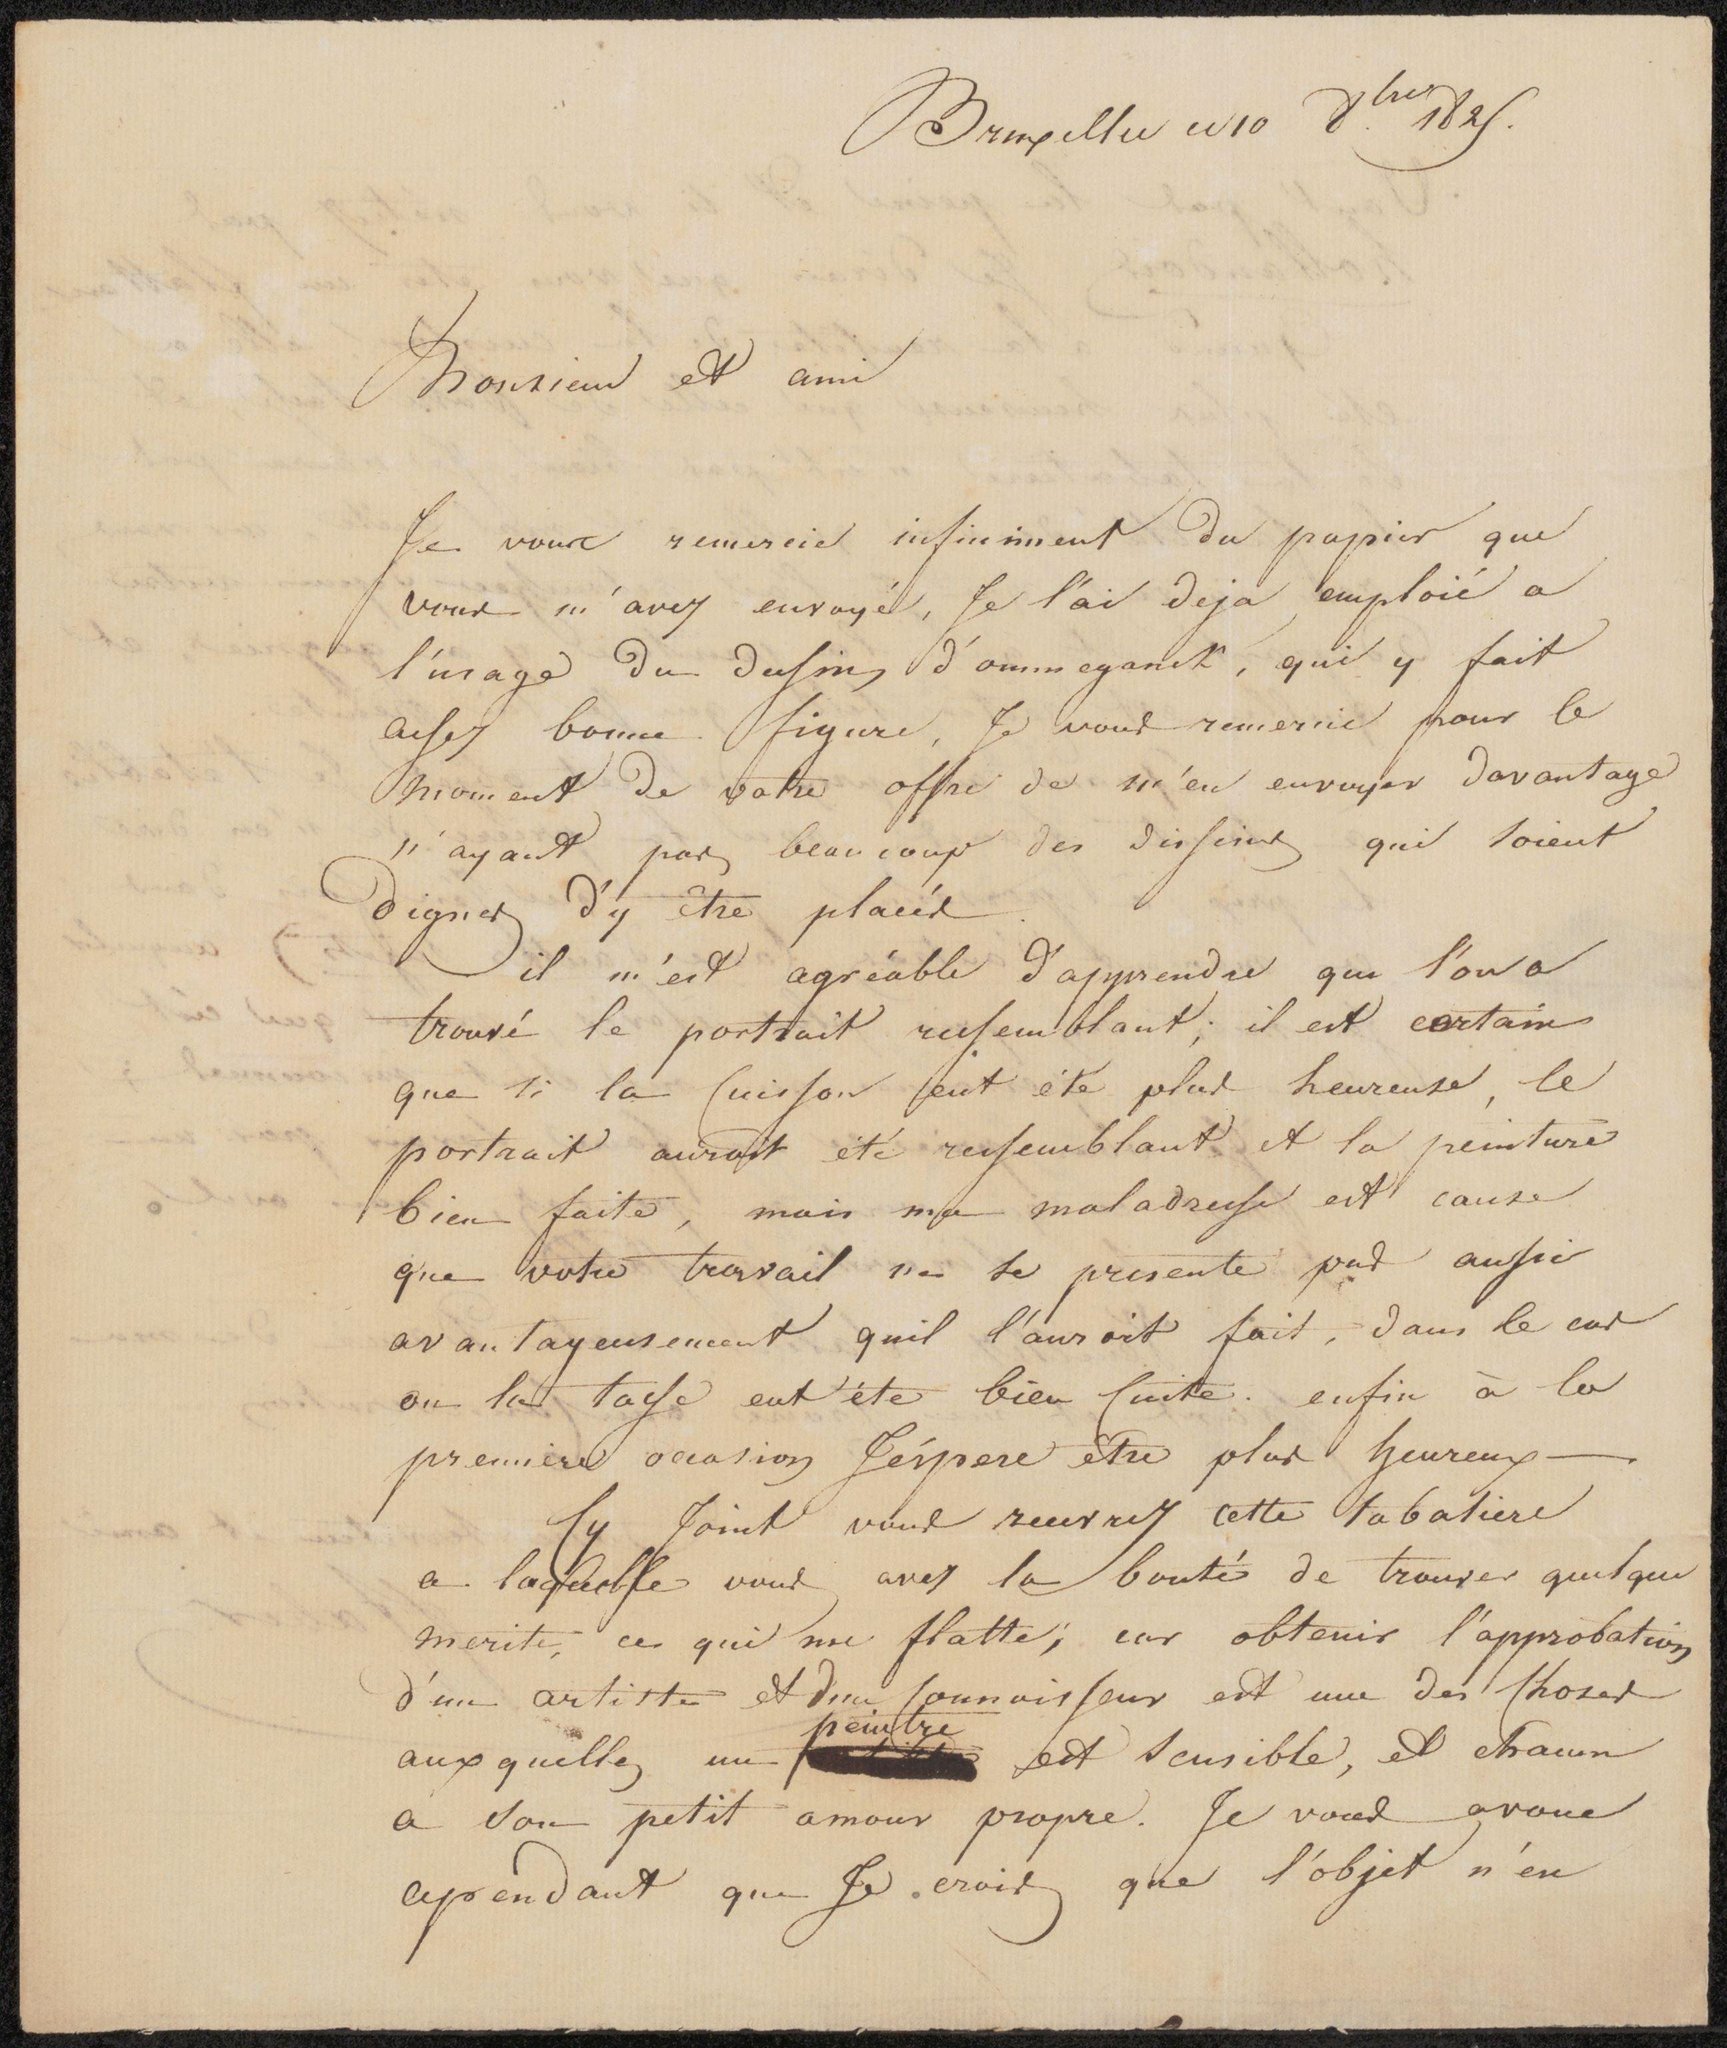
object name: letter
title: Brief aan Jean Zacharie Mazel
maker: frédéric théodore faber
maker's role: print maker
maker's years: 1782-1844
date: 1829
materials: ink, paper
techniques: pen, writing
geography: brussels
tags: the hague, draughtsman, politician, drawing, painting (including book-illumination, miniature-painting), historical persons (portraits and scenes from the life)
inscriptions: watermark, collector's mark: ‘RPK’